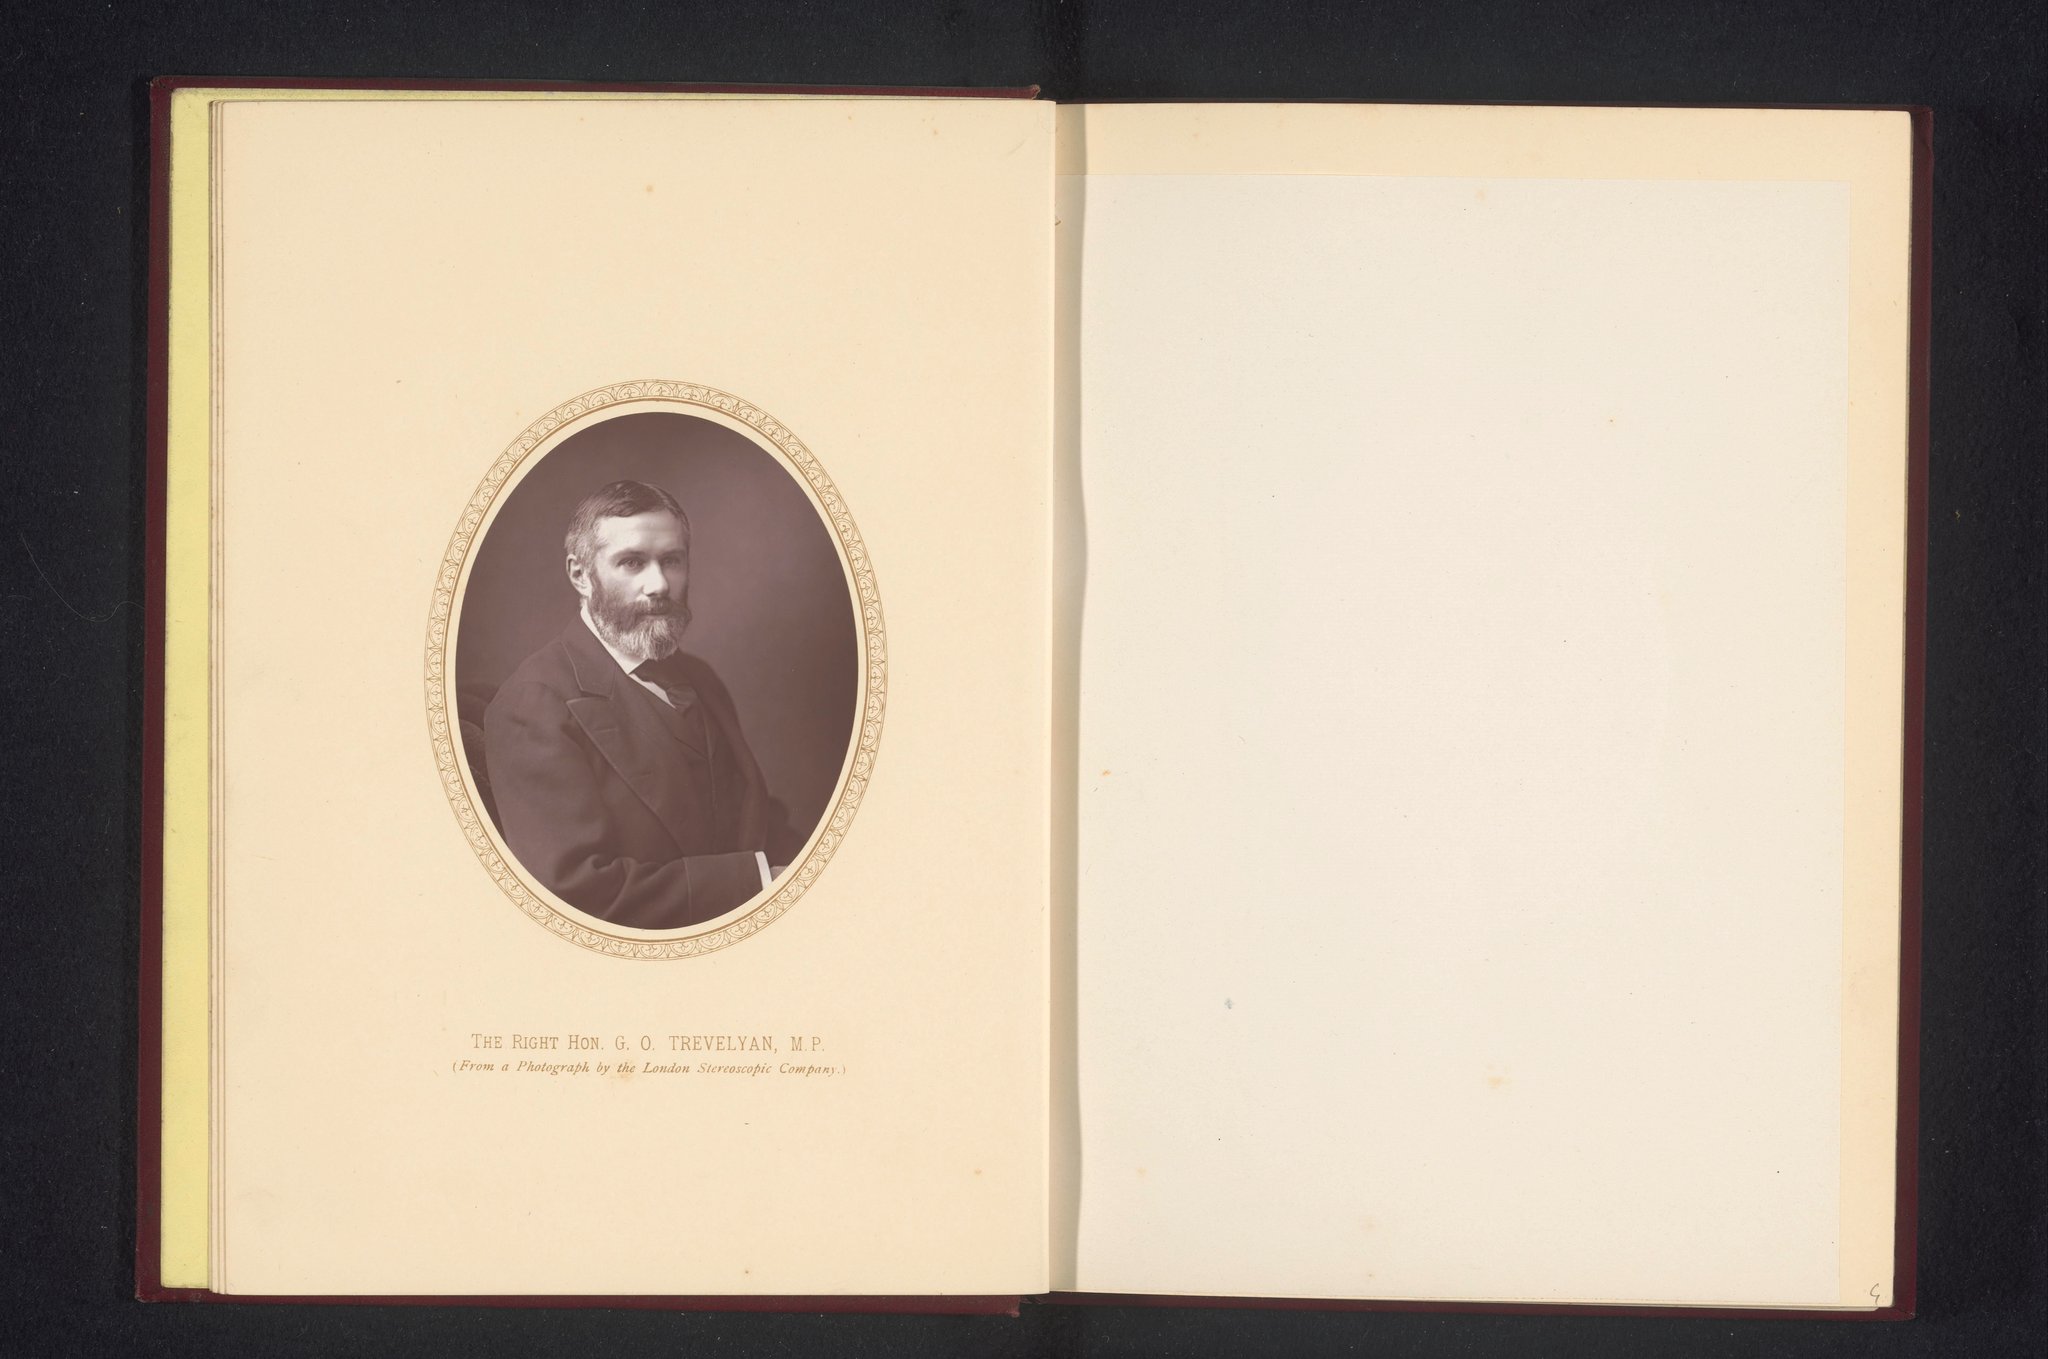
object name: page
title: The right hon. G.O. Trevelyan, M.P.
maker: Anonymous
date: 1875-1880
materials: paper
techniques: woodburytype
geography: london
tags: politician, e.g. party leader